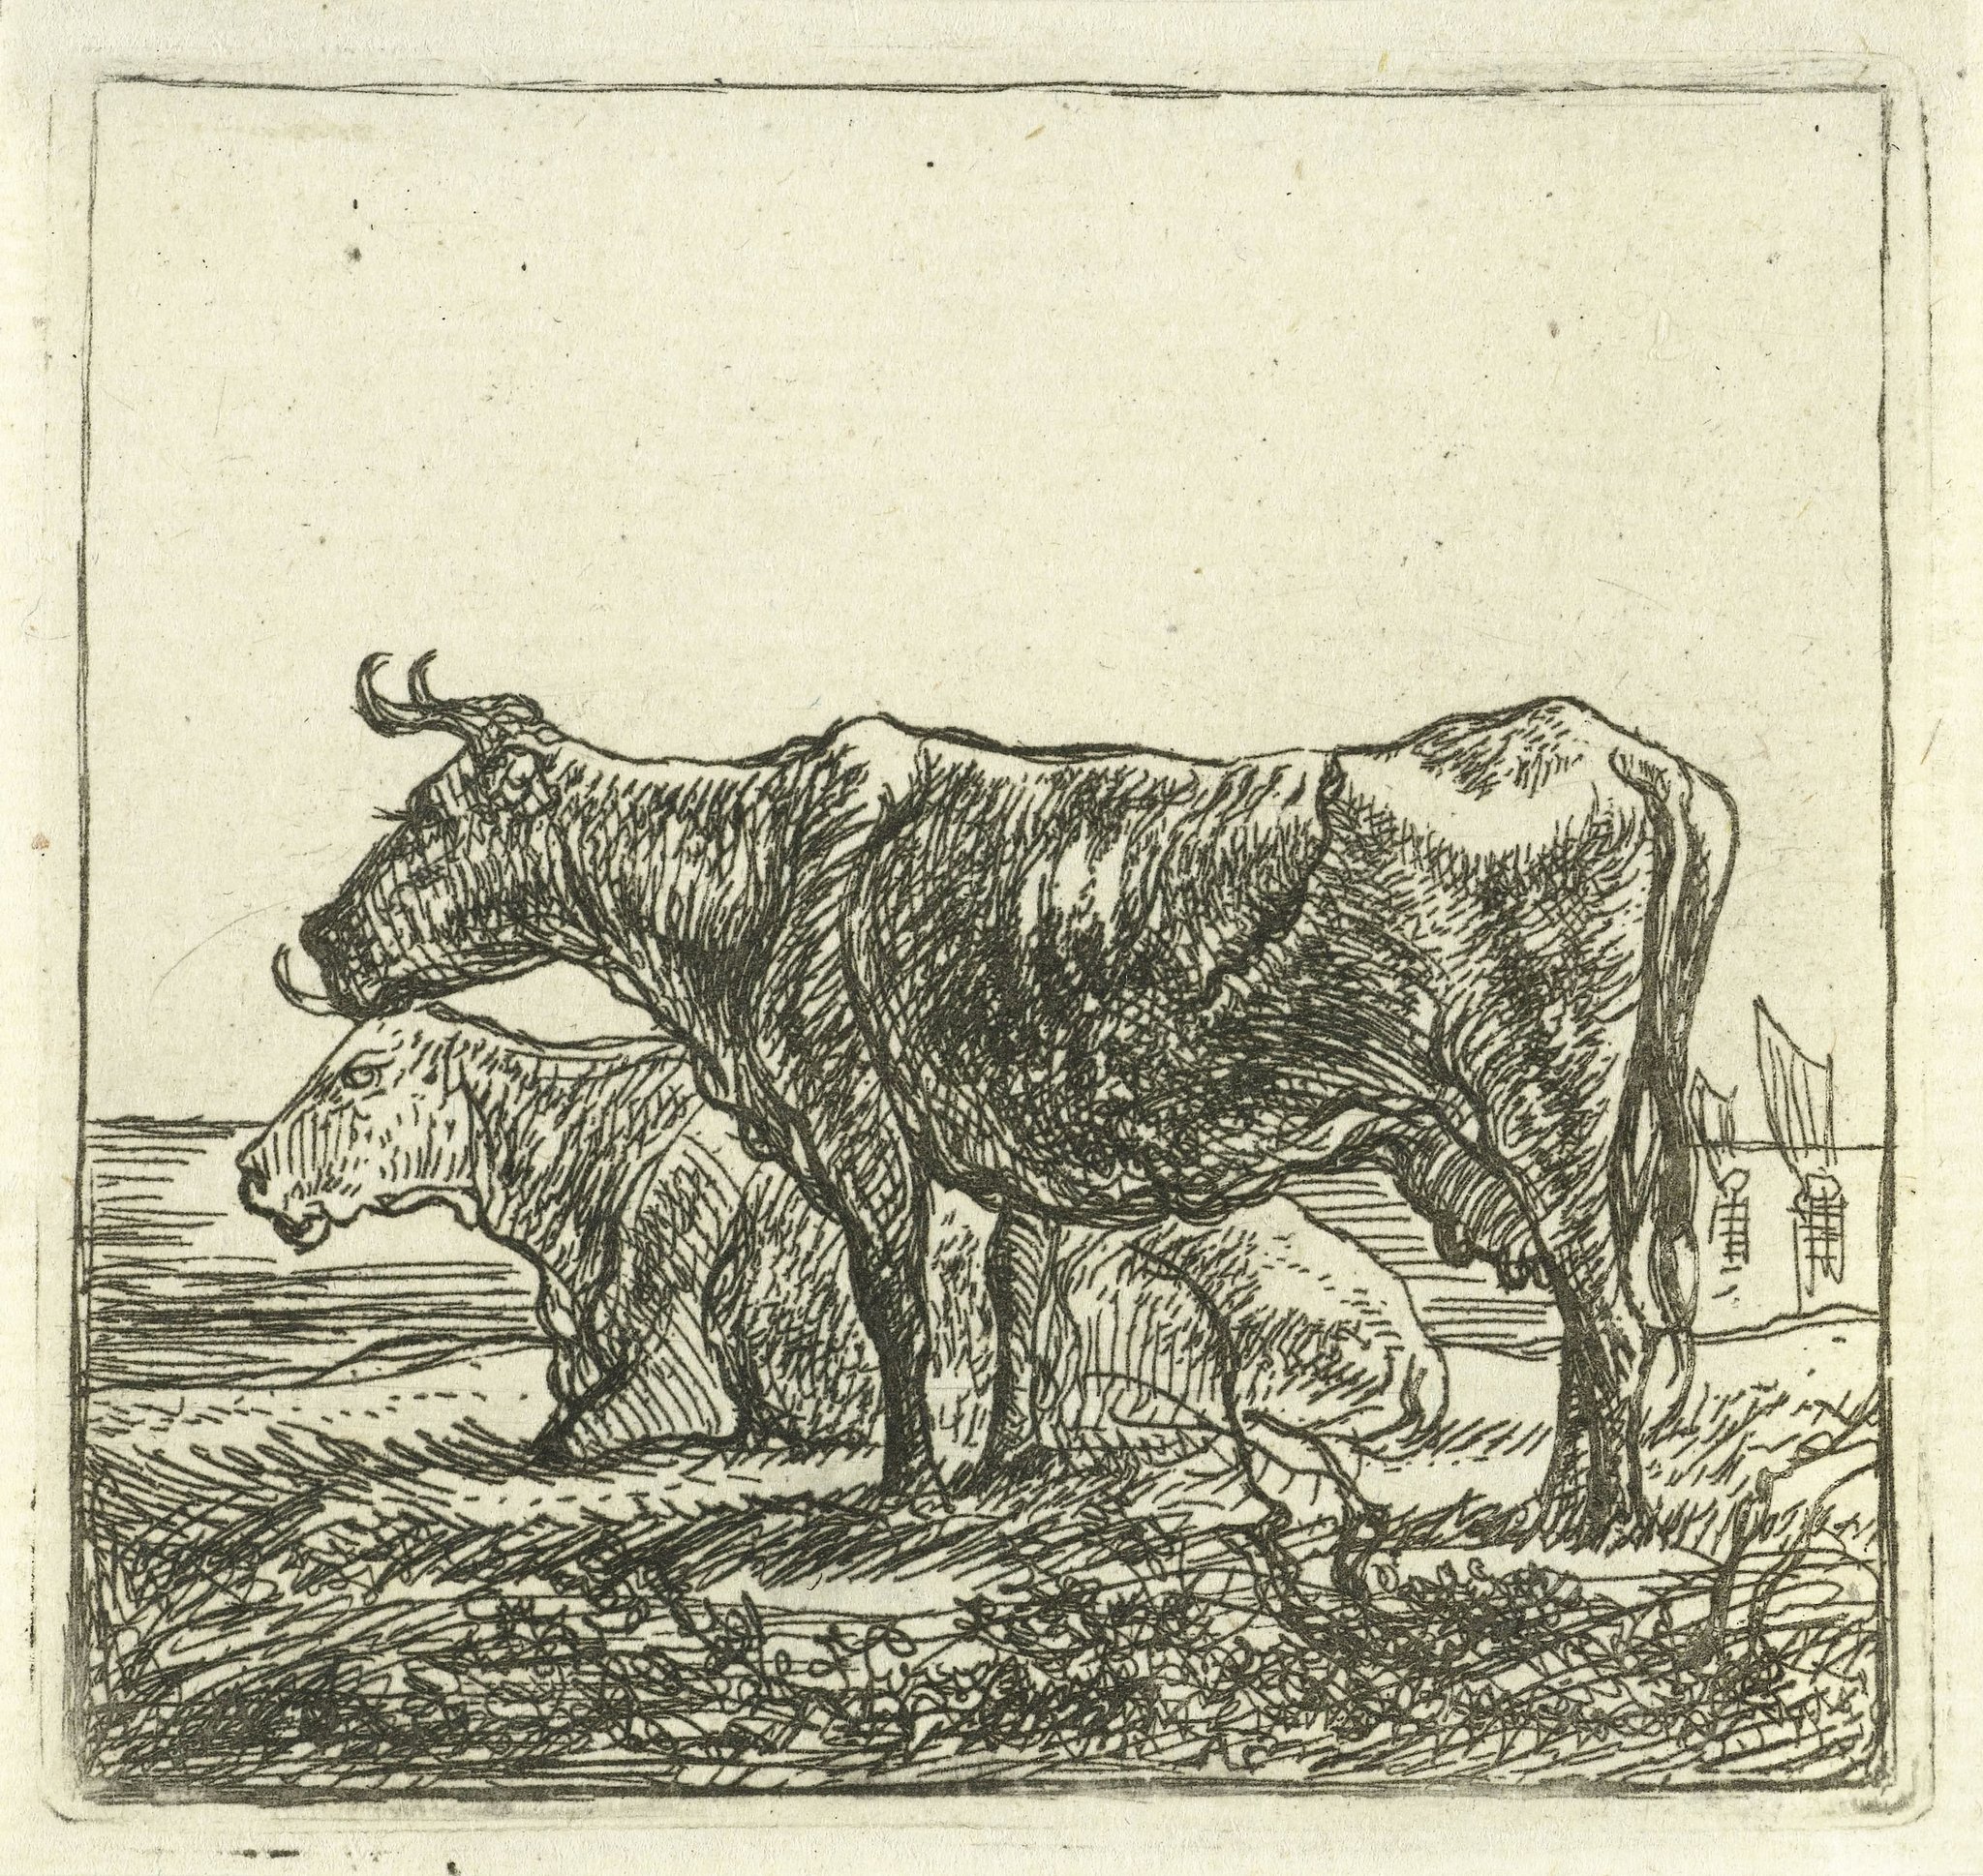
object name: print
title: Koeien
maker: aelbert cuyp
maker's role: draughtsman, painter, print maker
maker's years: 1620-1691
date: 1630-1691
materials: paper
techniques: etching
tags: cow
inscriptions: collector's mark: Lugt 2228, collector's mark: ‘FR’ Lugt 2133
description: Prent uit serie van zes prenten met koeien. Bij de derde staat werd door een anonieme vervaardiger een titelprent aan de serie toegevoegd.